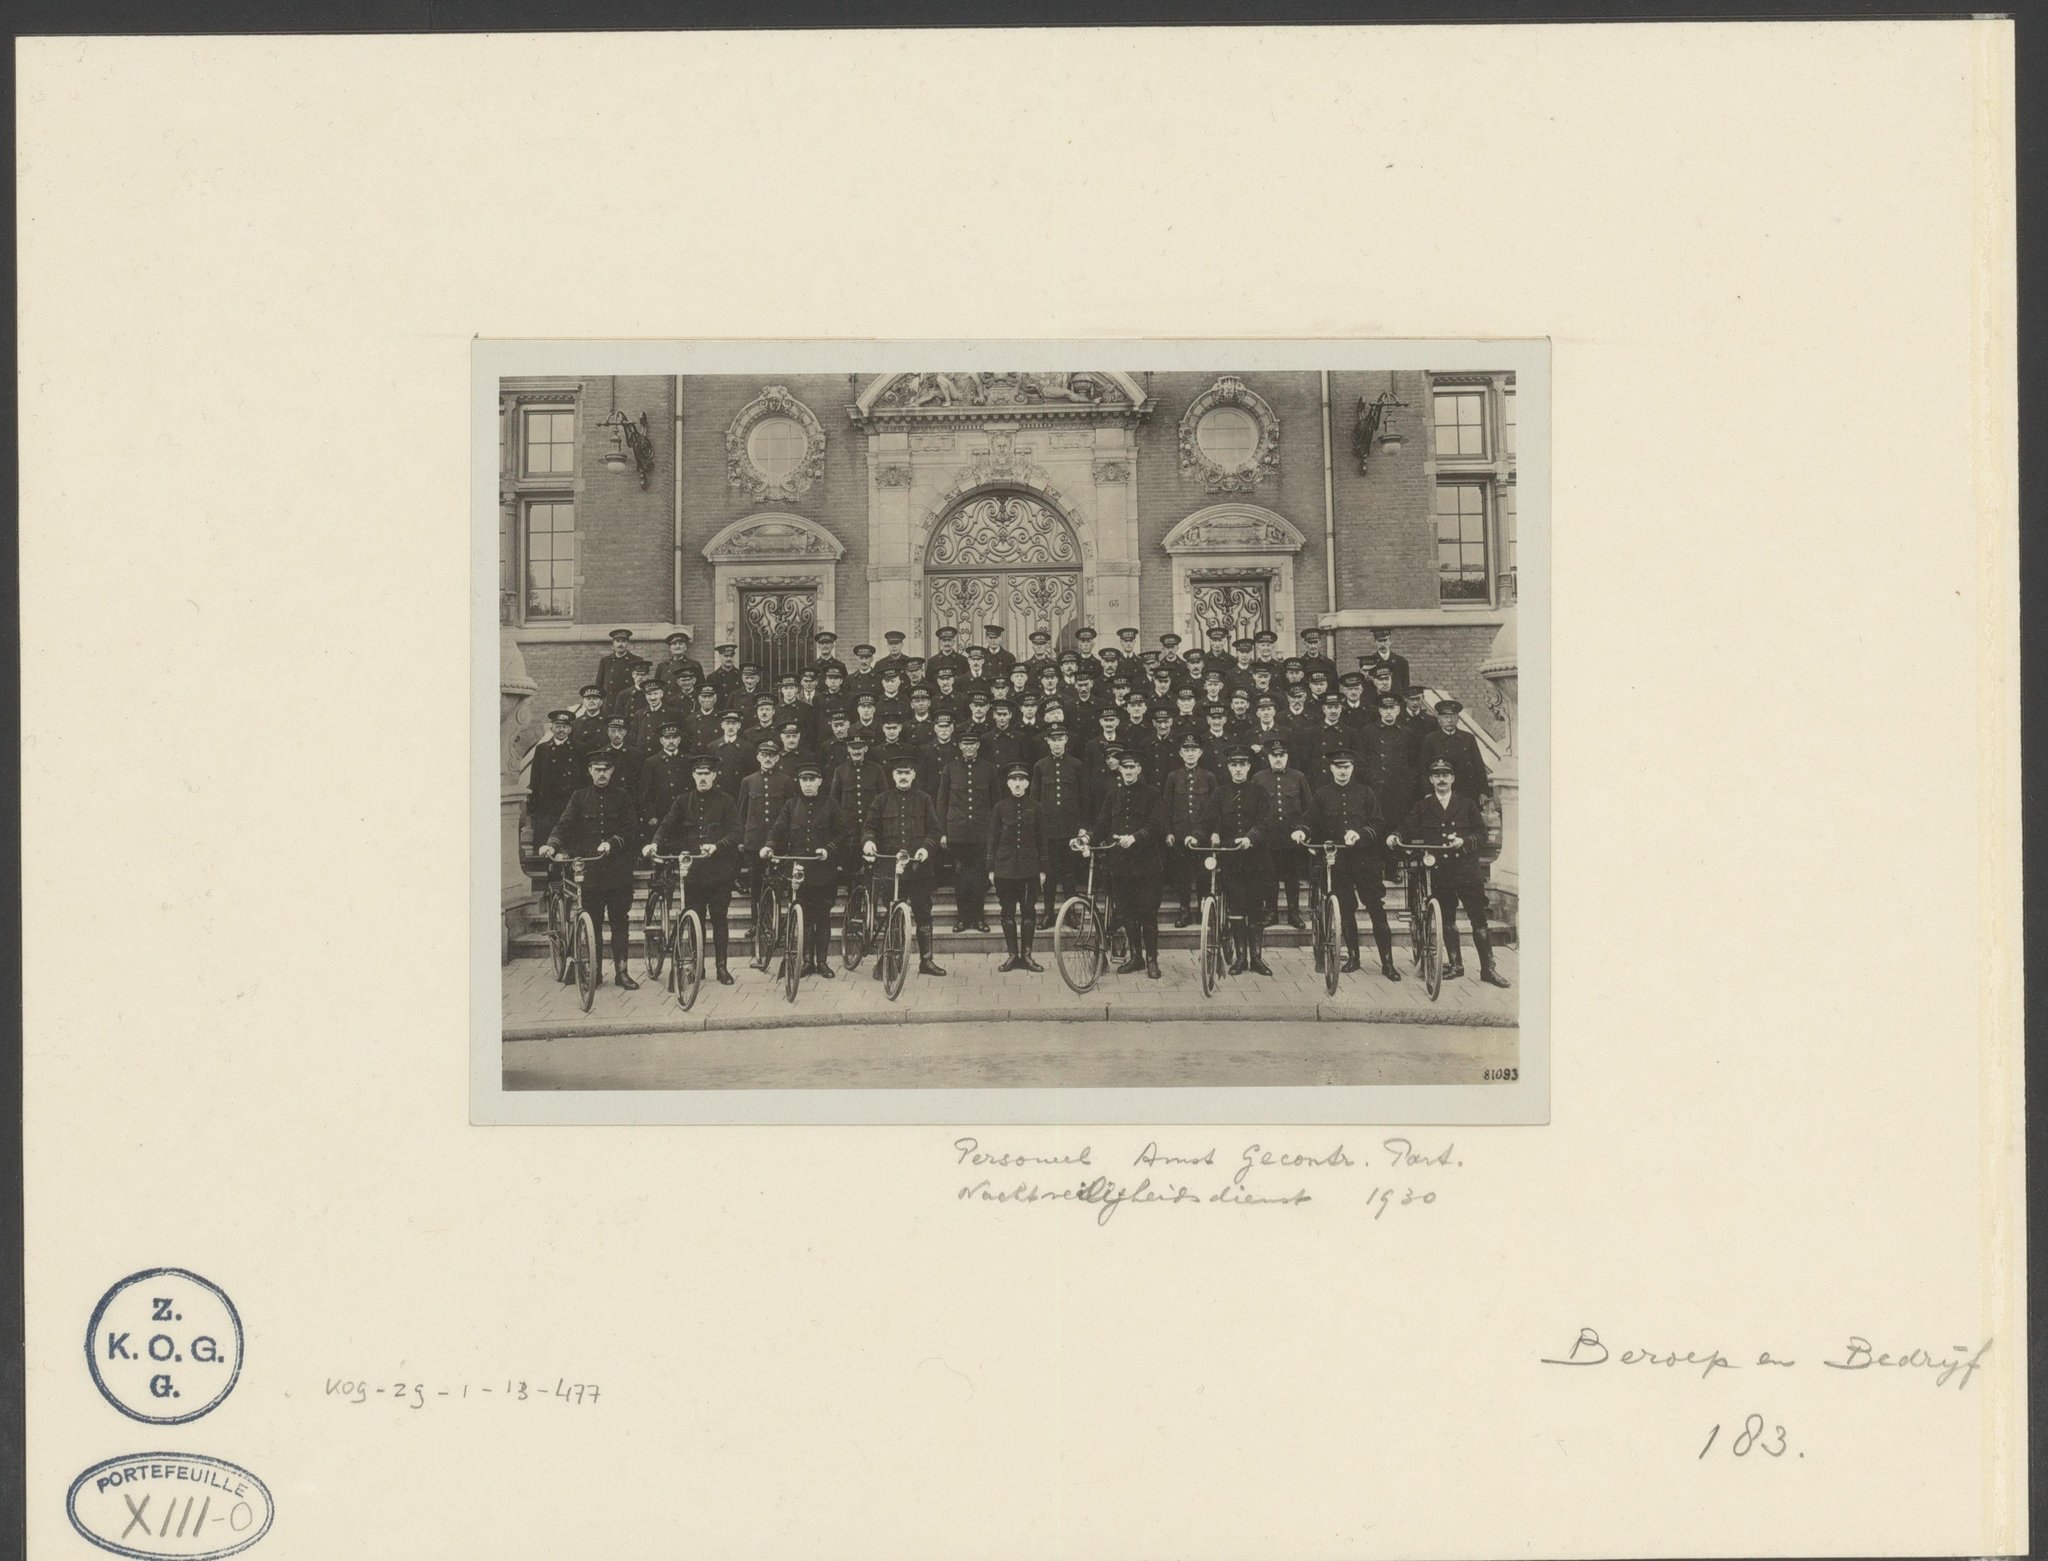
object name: photograph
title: Amsterdamse nachtveiligheidsdienst, 1930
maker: Anonymous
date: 1930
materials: paper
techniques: gelatin silver print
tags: guard duty, keeping sentry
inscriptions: stamp, collector's mark: Lugt 1641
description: Rechtsonder genummerd: 81093. Onderwerpsrubrieken binnen de Atlas Zeden en Gewoonten: Handel, Nijverheid en verkeer, Beroep en bedrijf, Mannelijk, Klapperman, omroeper, nachtwaker.